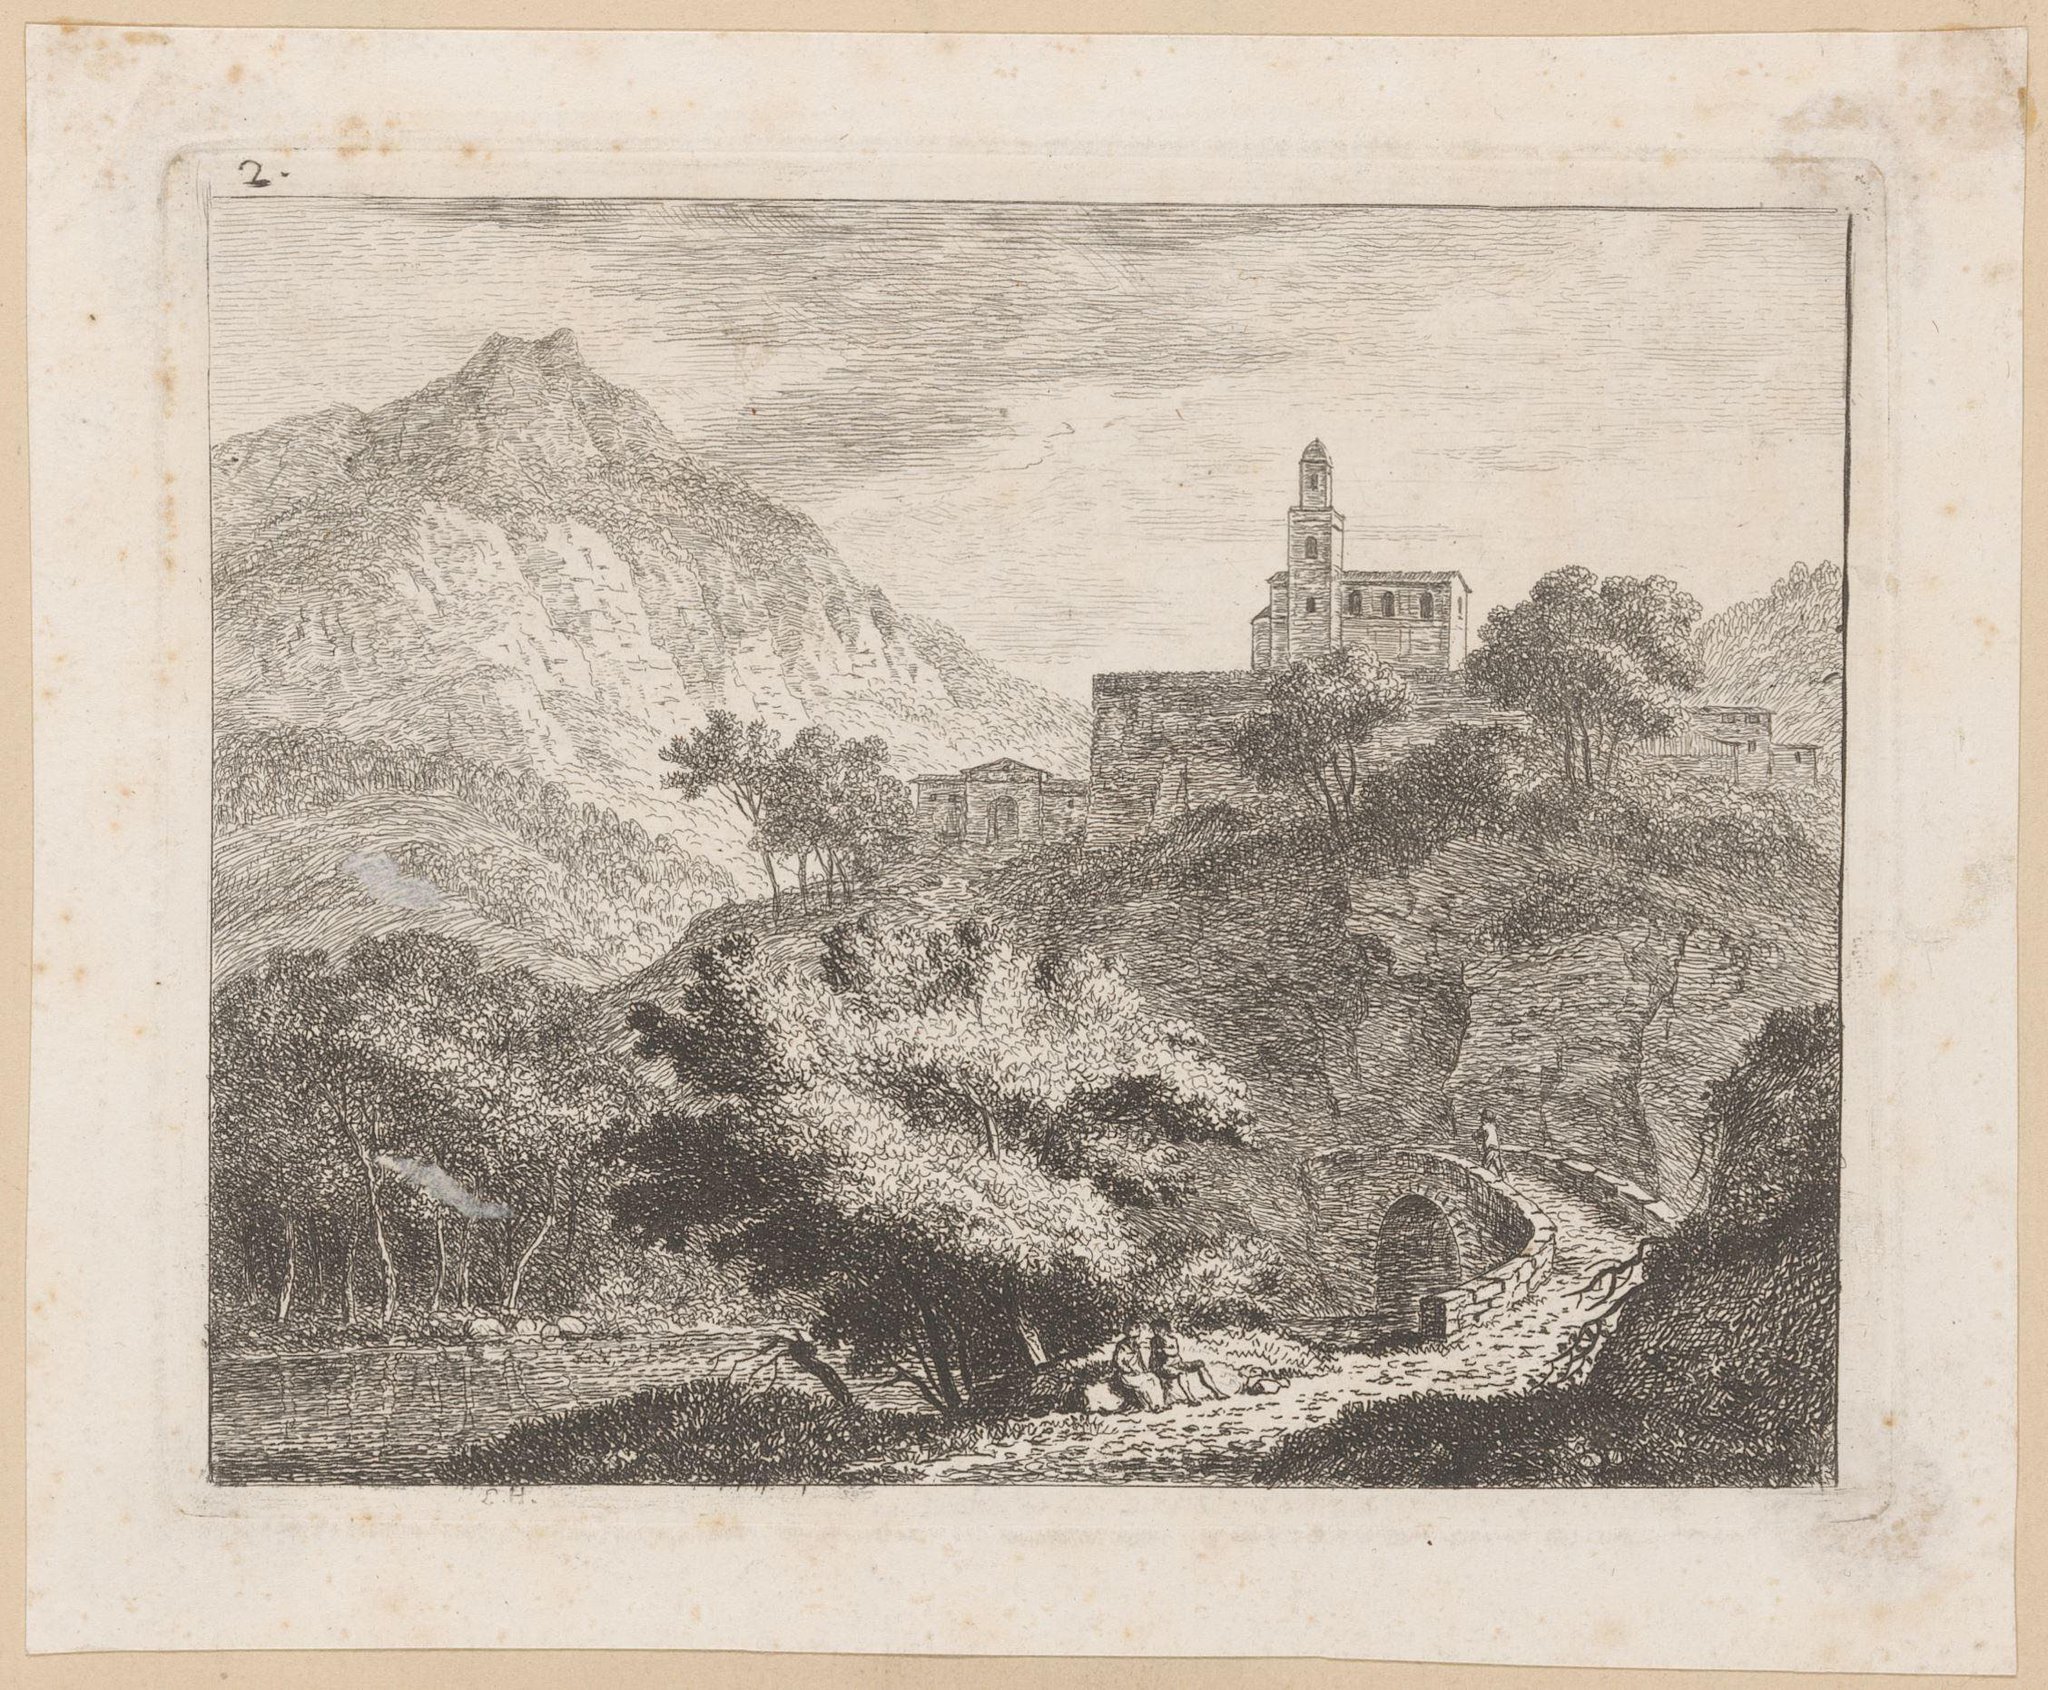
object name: print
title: Bergachtige landschappen met reizigers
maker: ludwig hess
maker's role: painter, print maker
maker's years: 1760-1800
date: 1798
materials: paper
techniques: etching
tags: landscapes with waters, waterscapes, seascapes (in the temperate zone), 'en route', traveller under way, mountains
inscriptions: collector's mark: Lugt 2228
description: Onderdeel van een serie van mogelijk tien prenten met bergachtige landschappen met reizigers. Prent nummer 10 in British Museum: 1878,0713.2123.